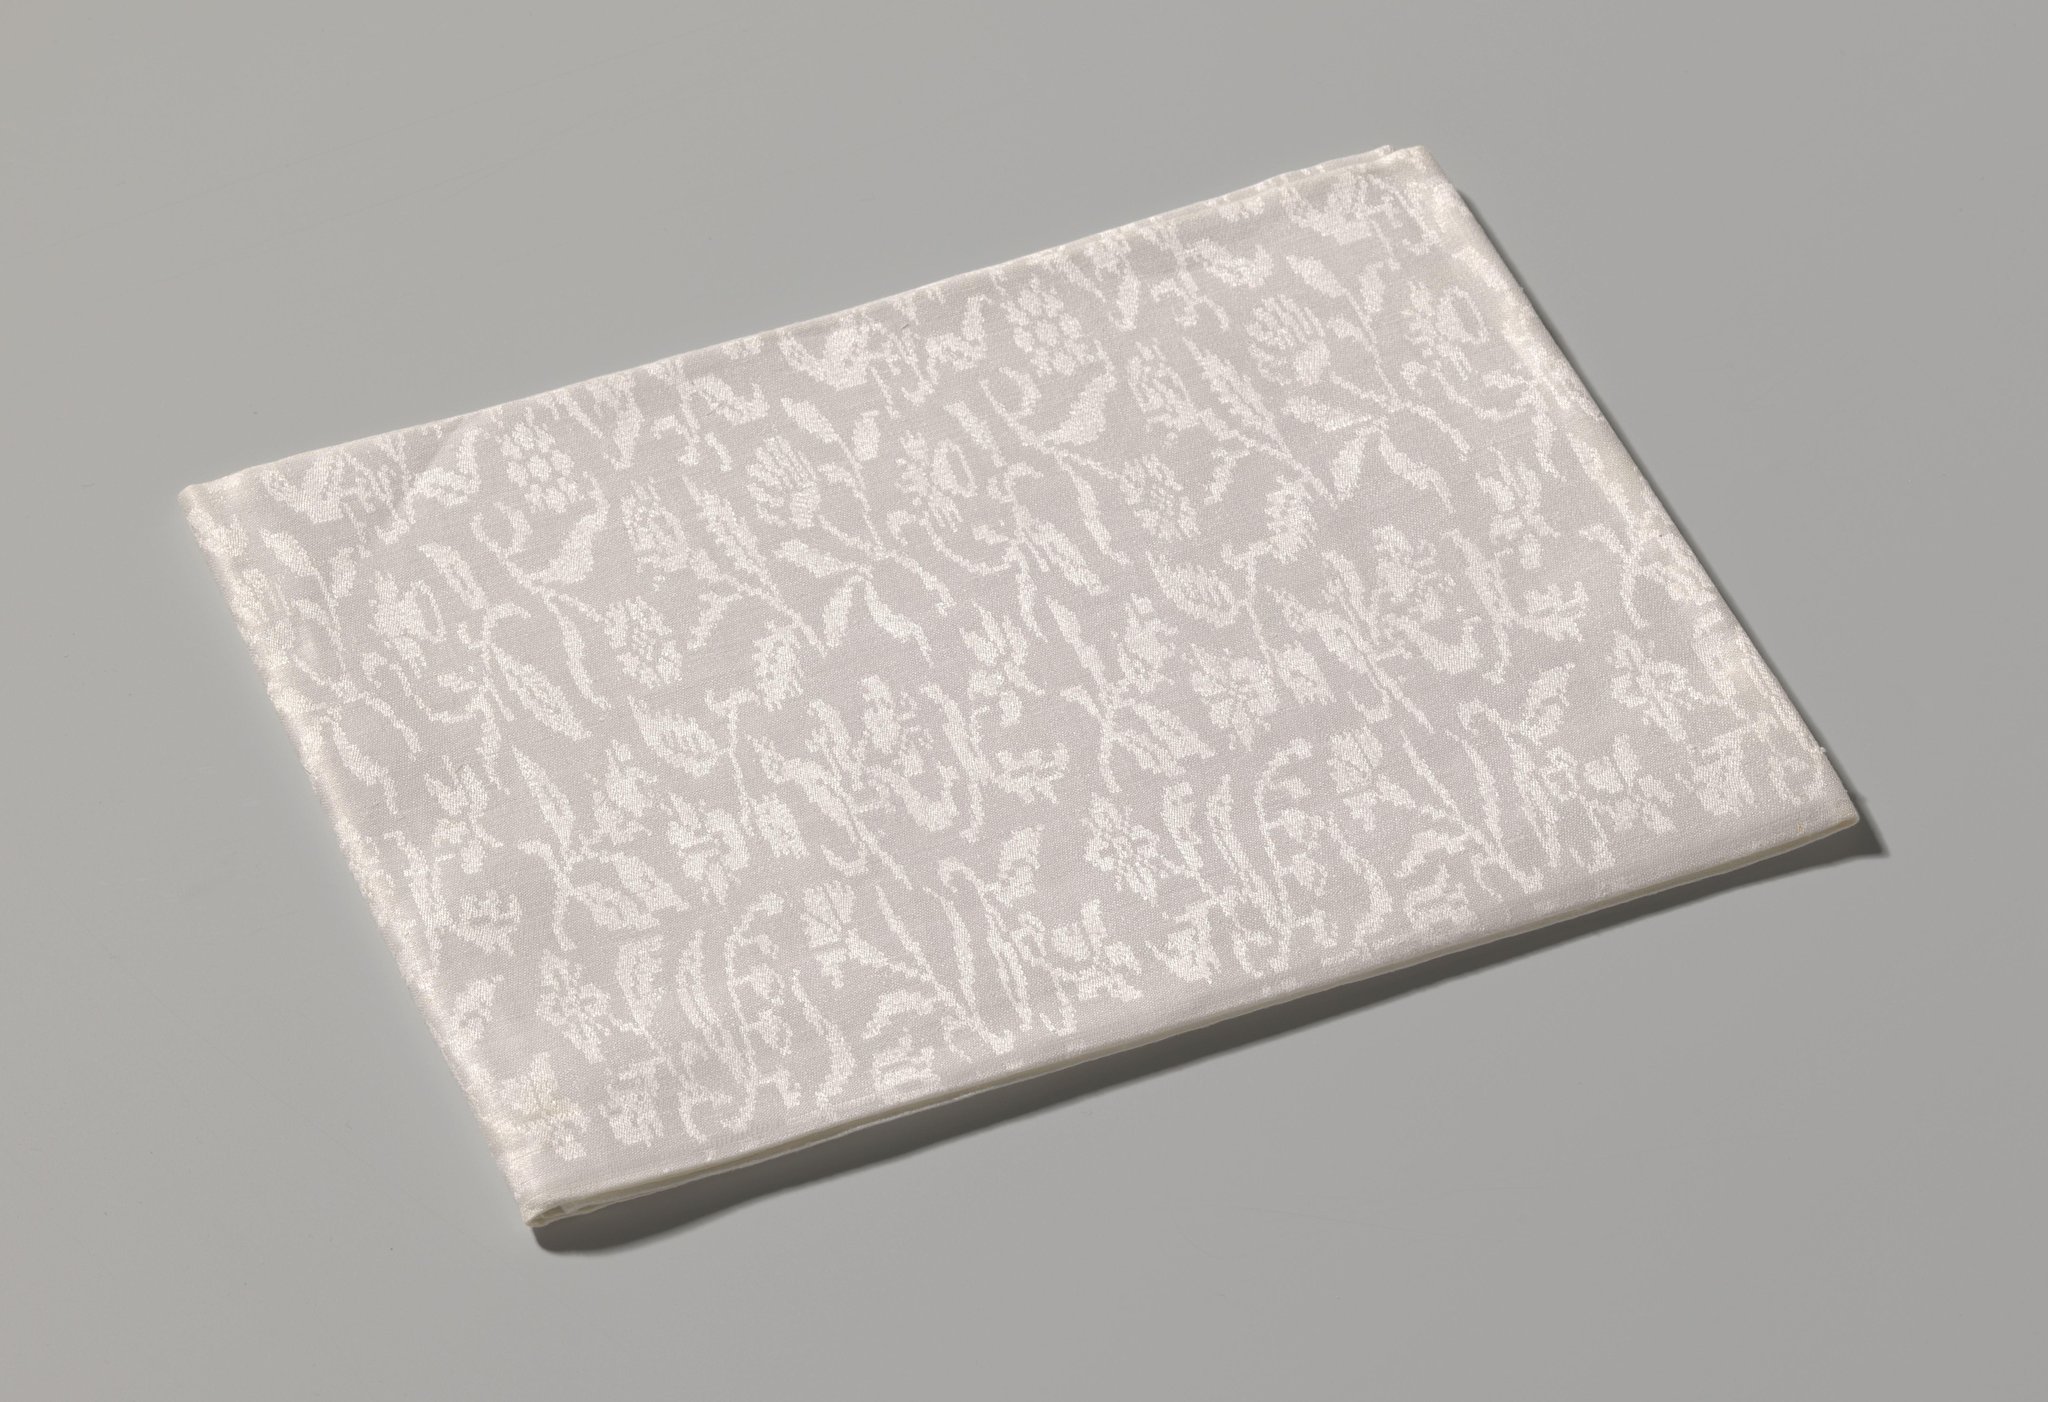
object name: fragment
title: Tafellaken, fragment, met patroon van alternerende rijen van naar links zwenkende tulpen en naar rechts zwenkende granaatappels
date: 1740-1749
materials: linen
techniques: damask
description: Fragment van een wit linnen damasten tafellaken met repeterend patroon van alternerende rijen van naar links zwenkende tulpen en naar rechts zwenkende granaatappels